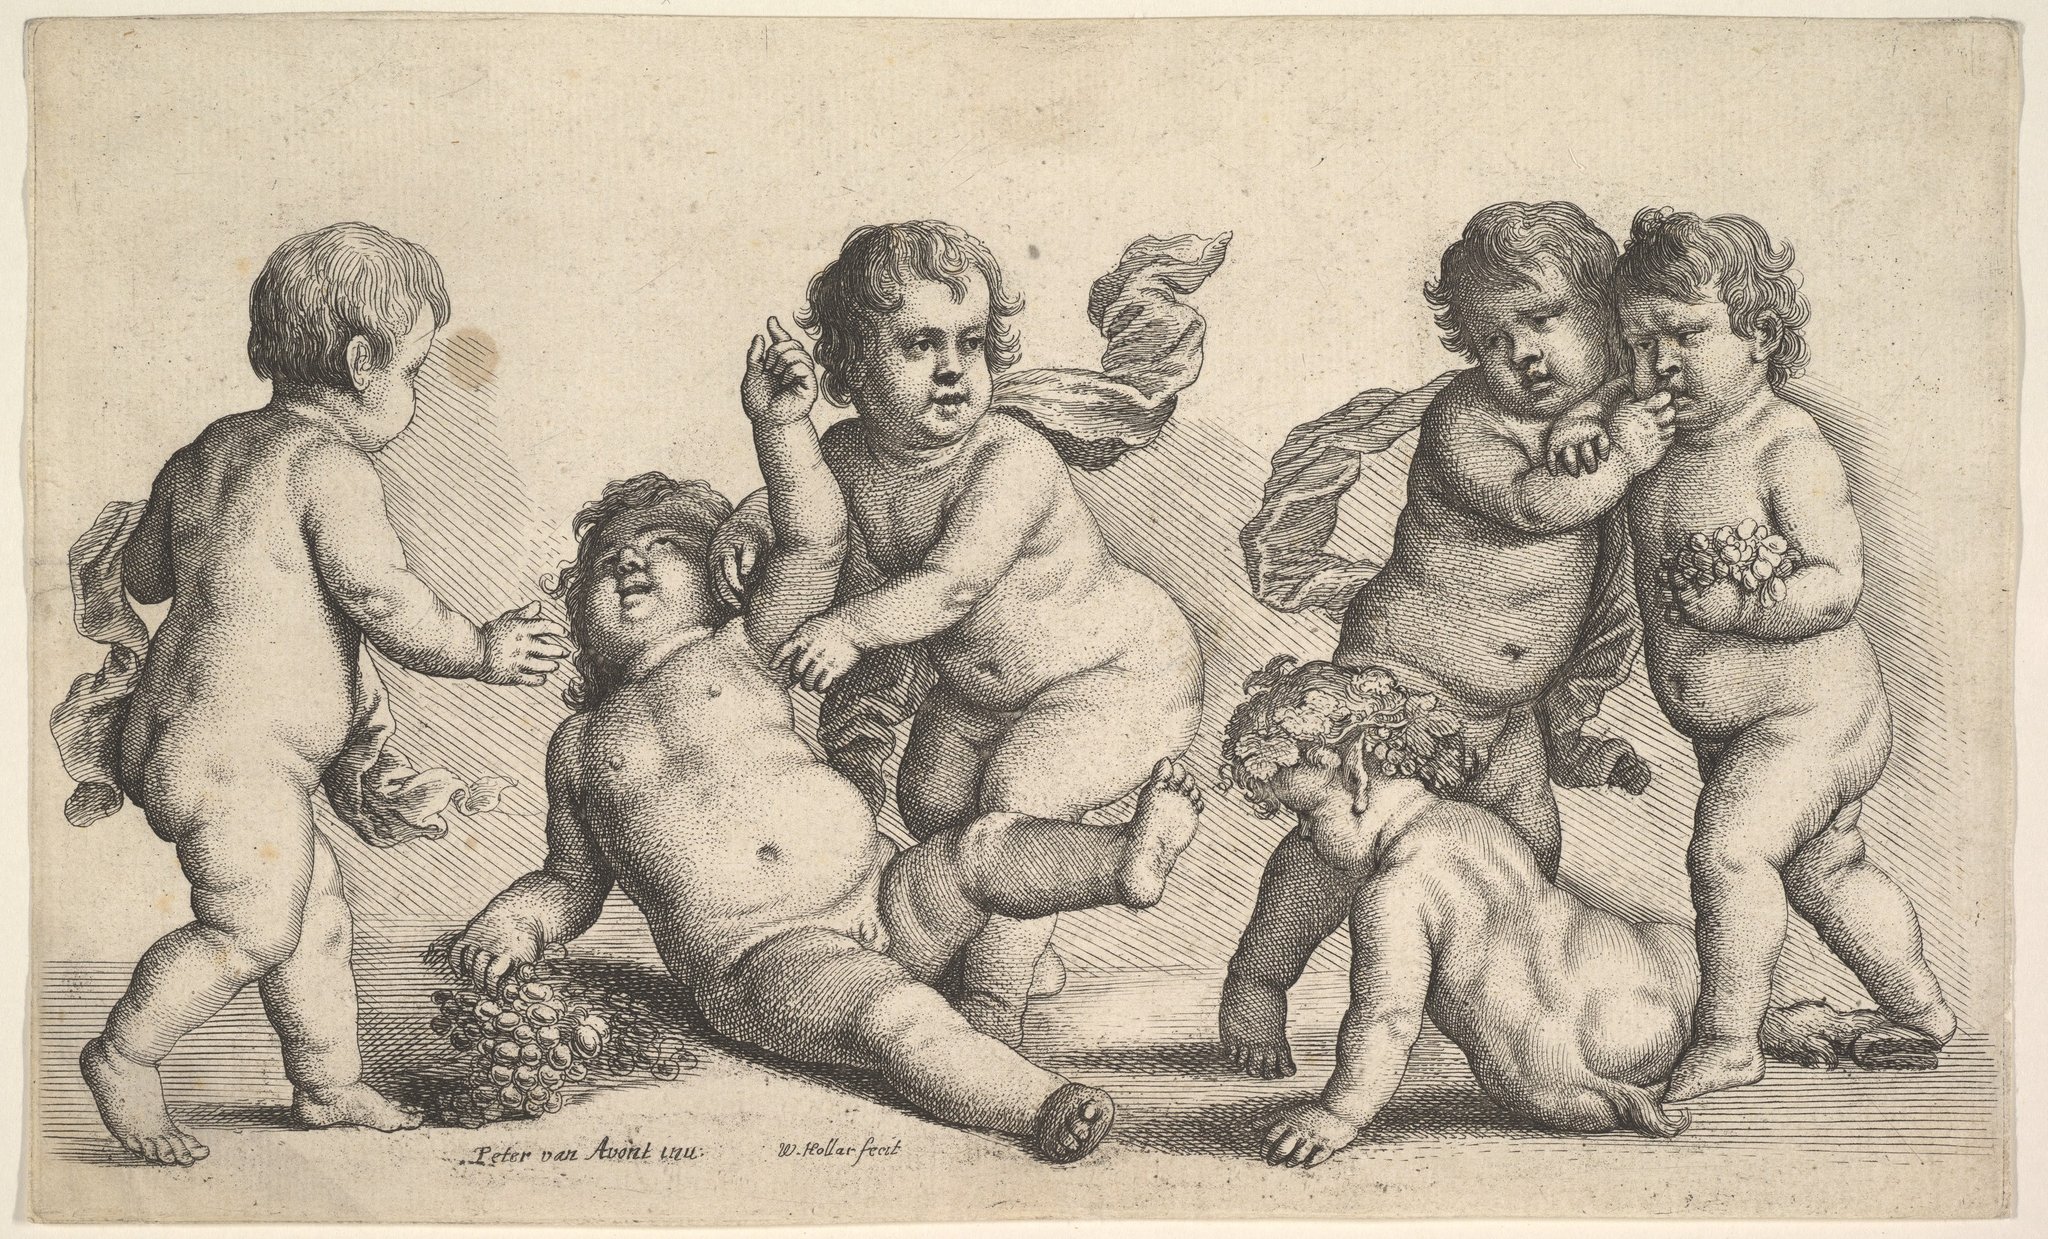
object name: print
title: Five boys and a satyr, from "Paedopaegnion"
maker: wenceslaus hollar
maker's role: artist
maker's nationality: bohemian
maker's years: 1607-1677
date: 1646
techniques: etching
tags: boys,satyrs